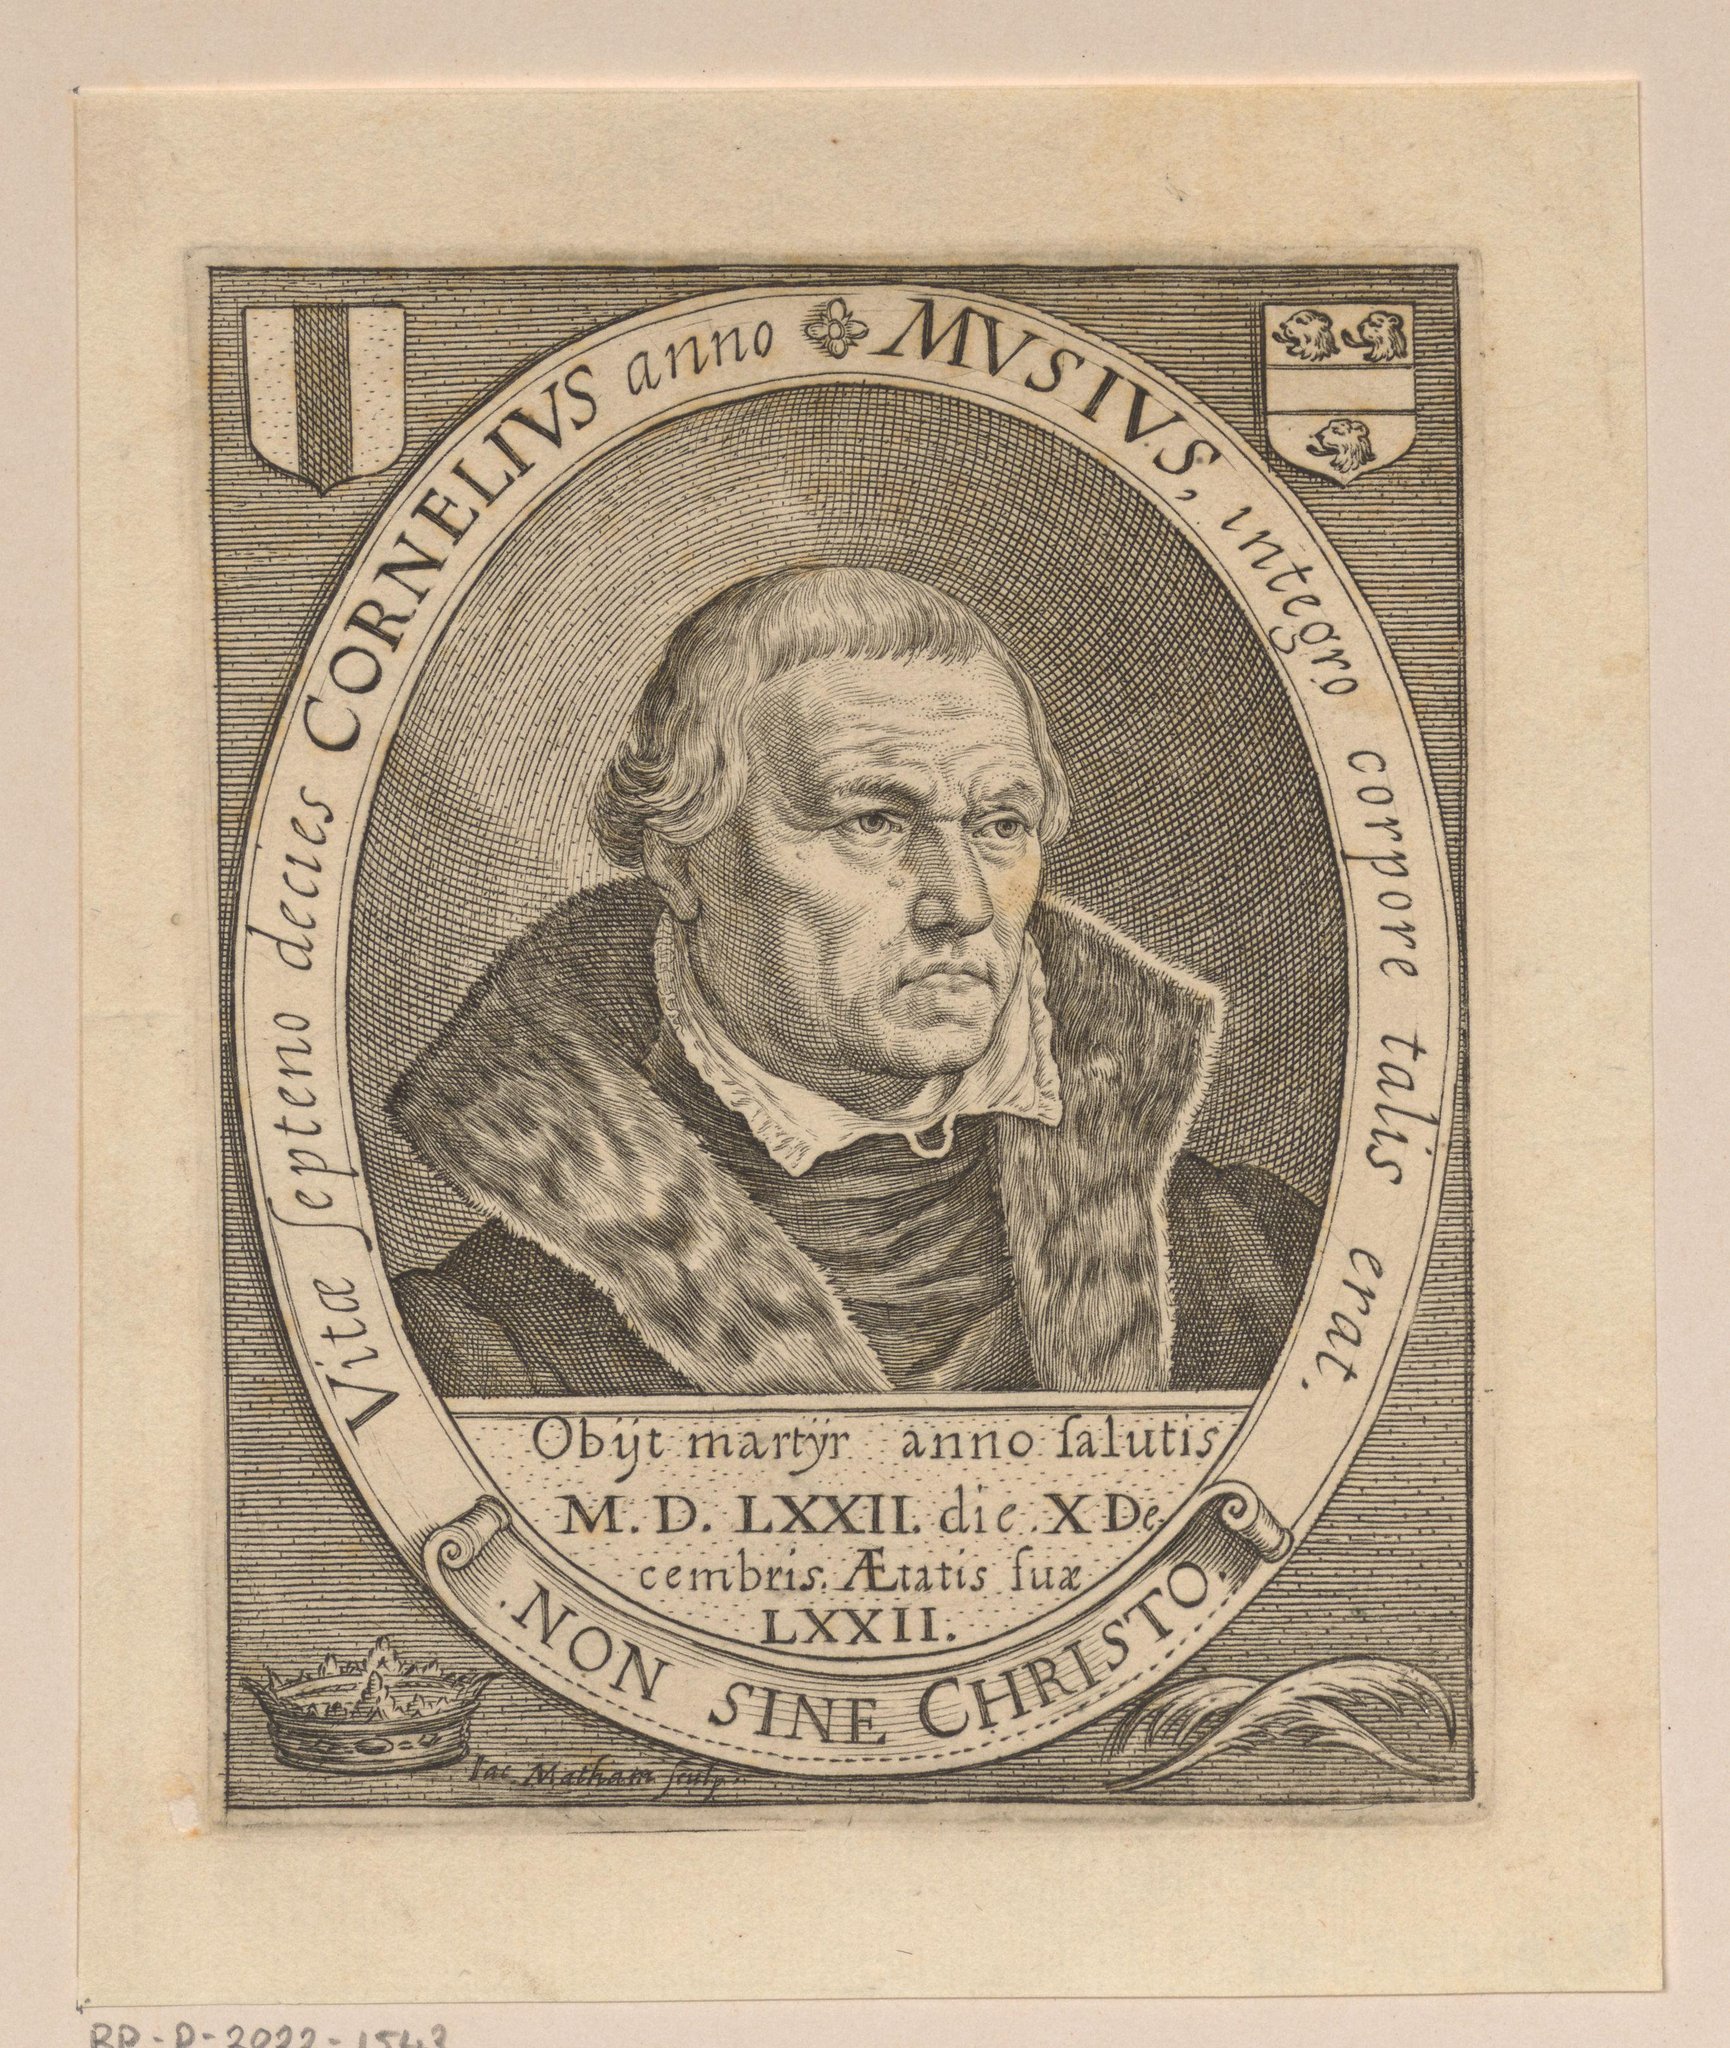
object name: print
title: Portret van Cornelis Musius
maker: jacob matham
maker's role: draughtsman, print maker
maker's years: 1571-1631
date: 1600-1610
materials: paper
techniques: engraving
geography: haarlem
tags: delft, leiden, priest, cornelis musius, theologian, historical persons, portrait of a writer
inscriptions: collector's mark: Lugt 2228